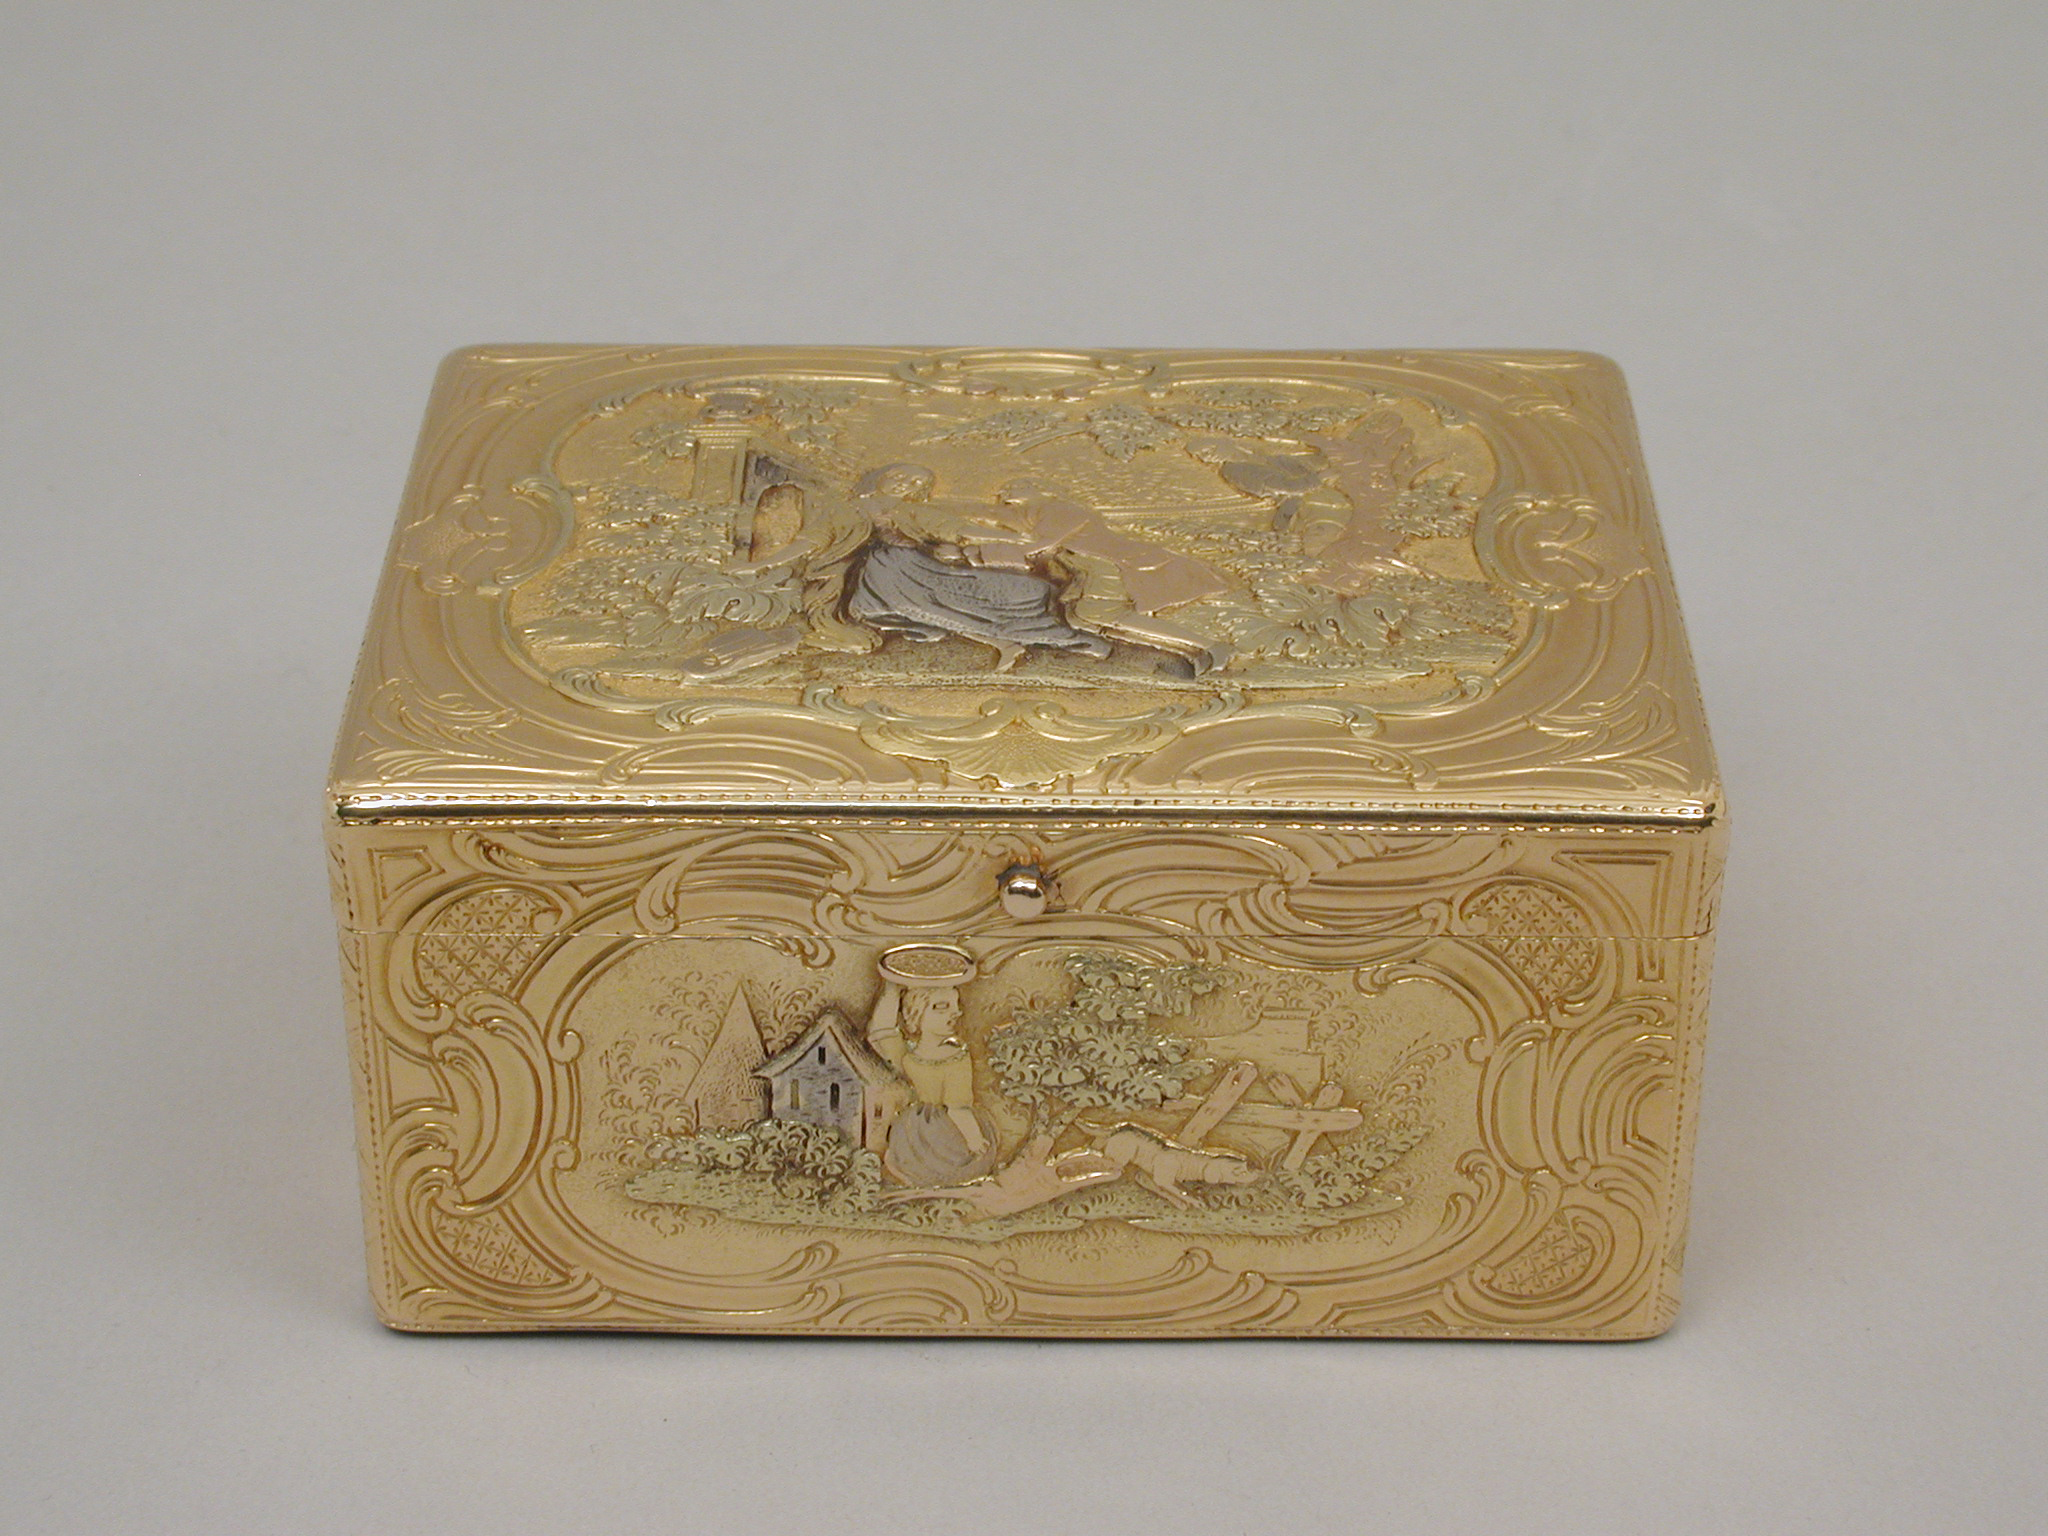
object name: snuffbox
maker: les frères toussaint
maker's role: maker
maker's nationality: french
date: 1770-1780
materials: gold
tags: fruit,women